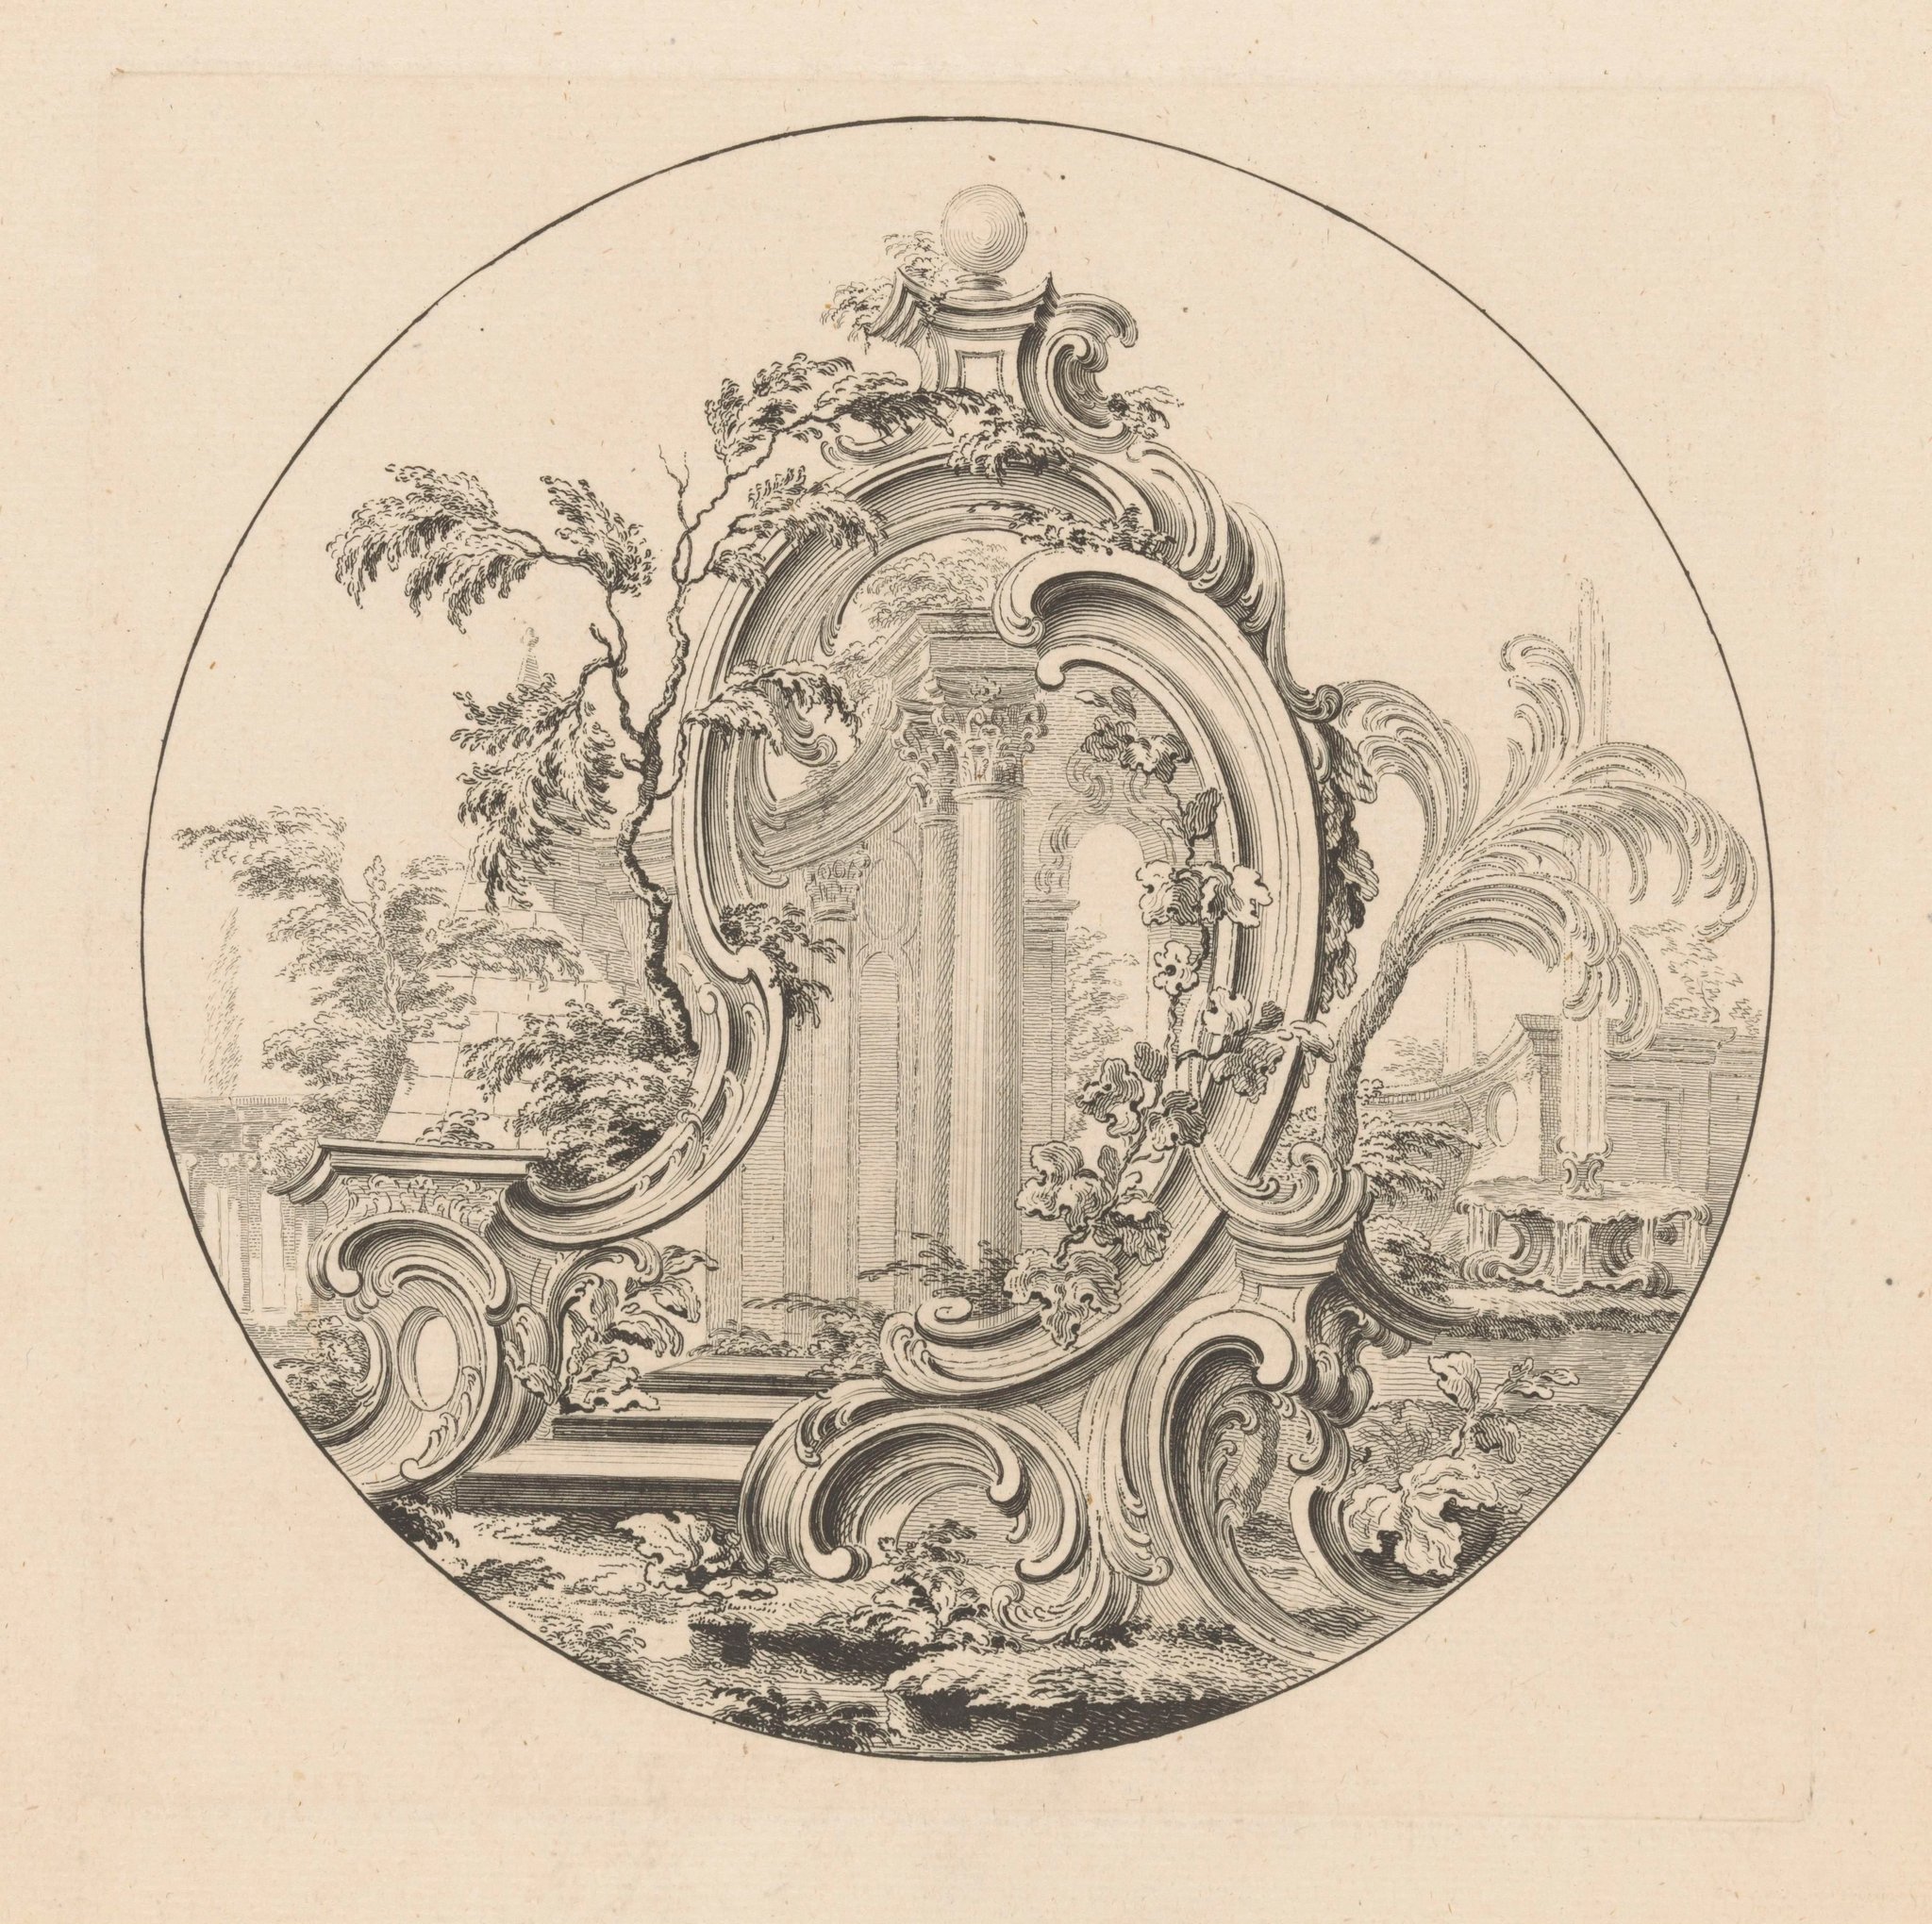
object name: ornament print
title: Cartouche in landschap met colonnades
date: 1752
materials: paper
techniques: etching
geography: london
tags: colonnade, garden fountain, ornament ~ cartouche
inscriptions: collector's mark: Lugt 2228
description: In de stijl van de serie A New Drawing Book of Ornaments (...) van Matthias Lock.